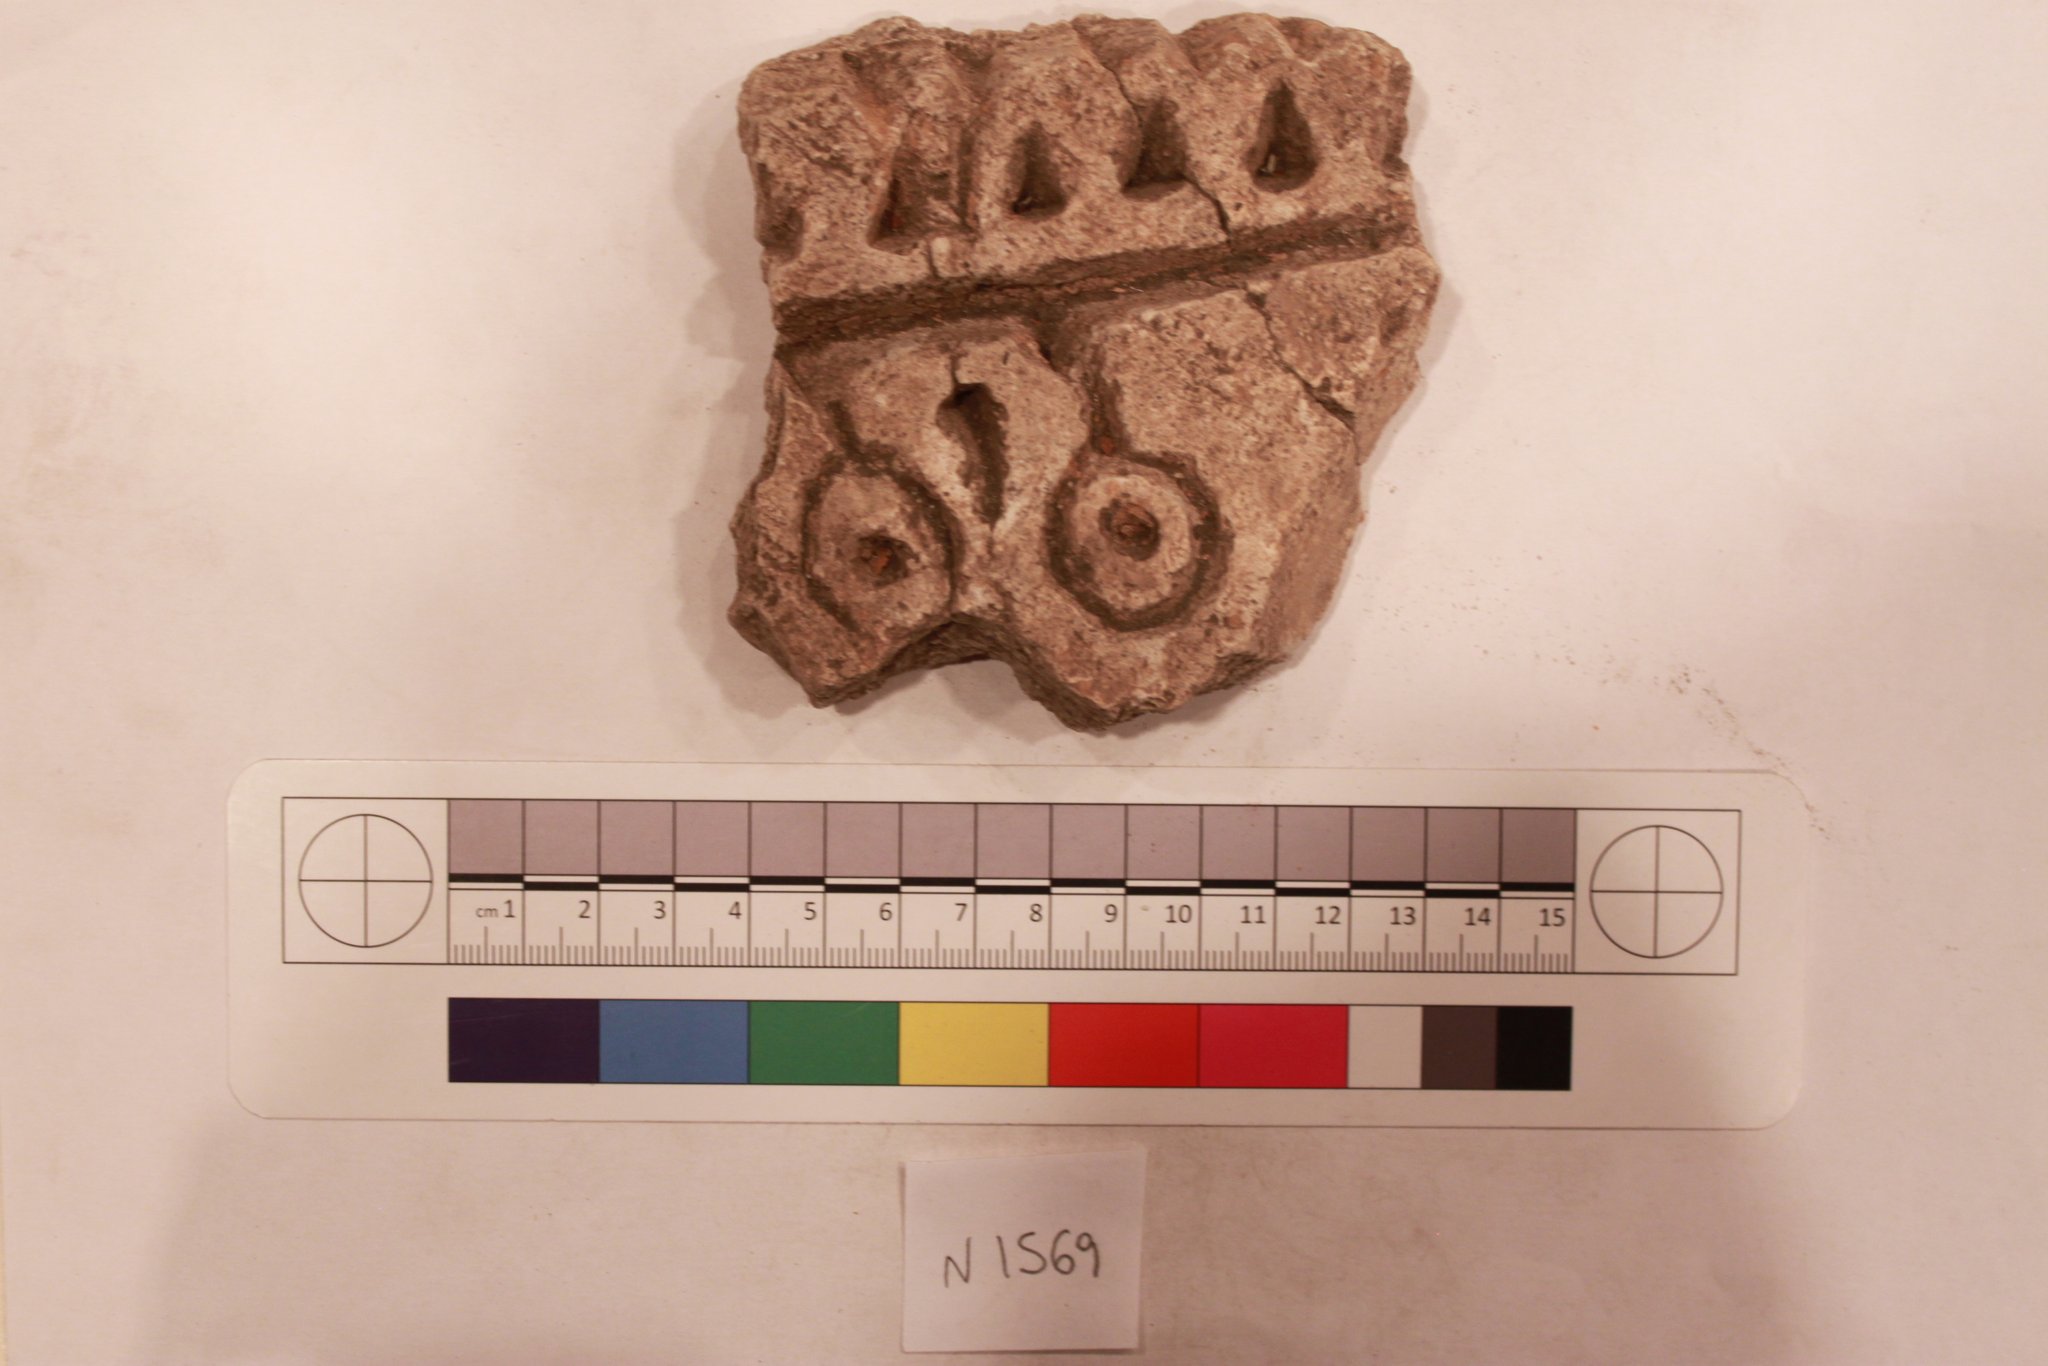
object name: fragment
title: Stucco Fragment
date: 701-1200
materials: plaster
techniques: carving, painting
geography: iran